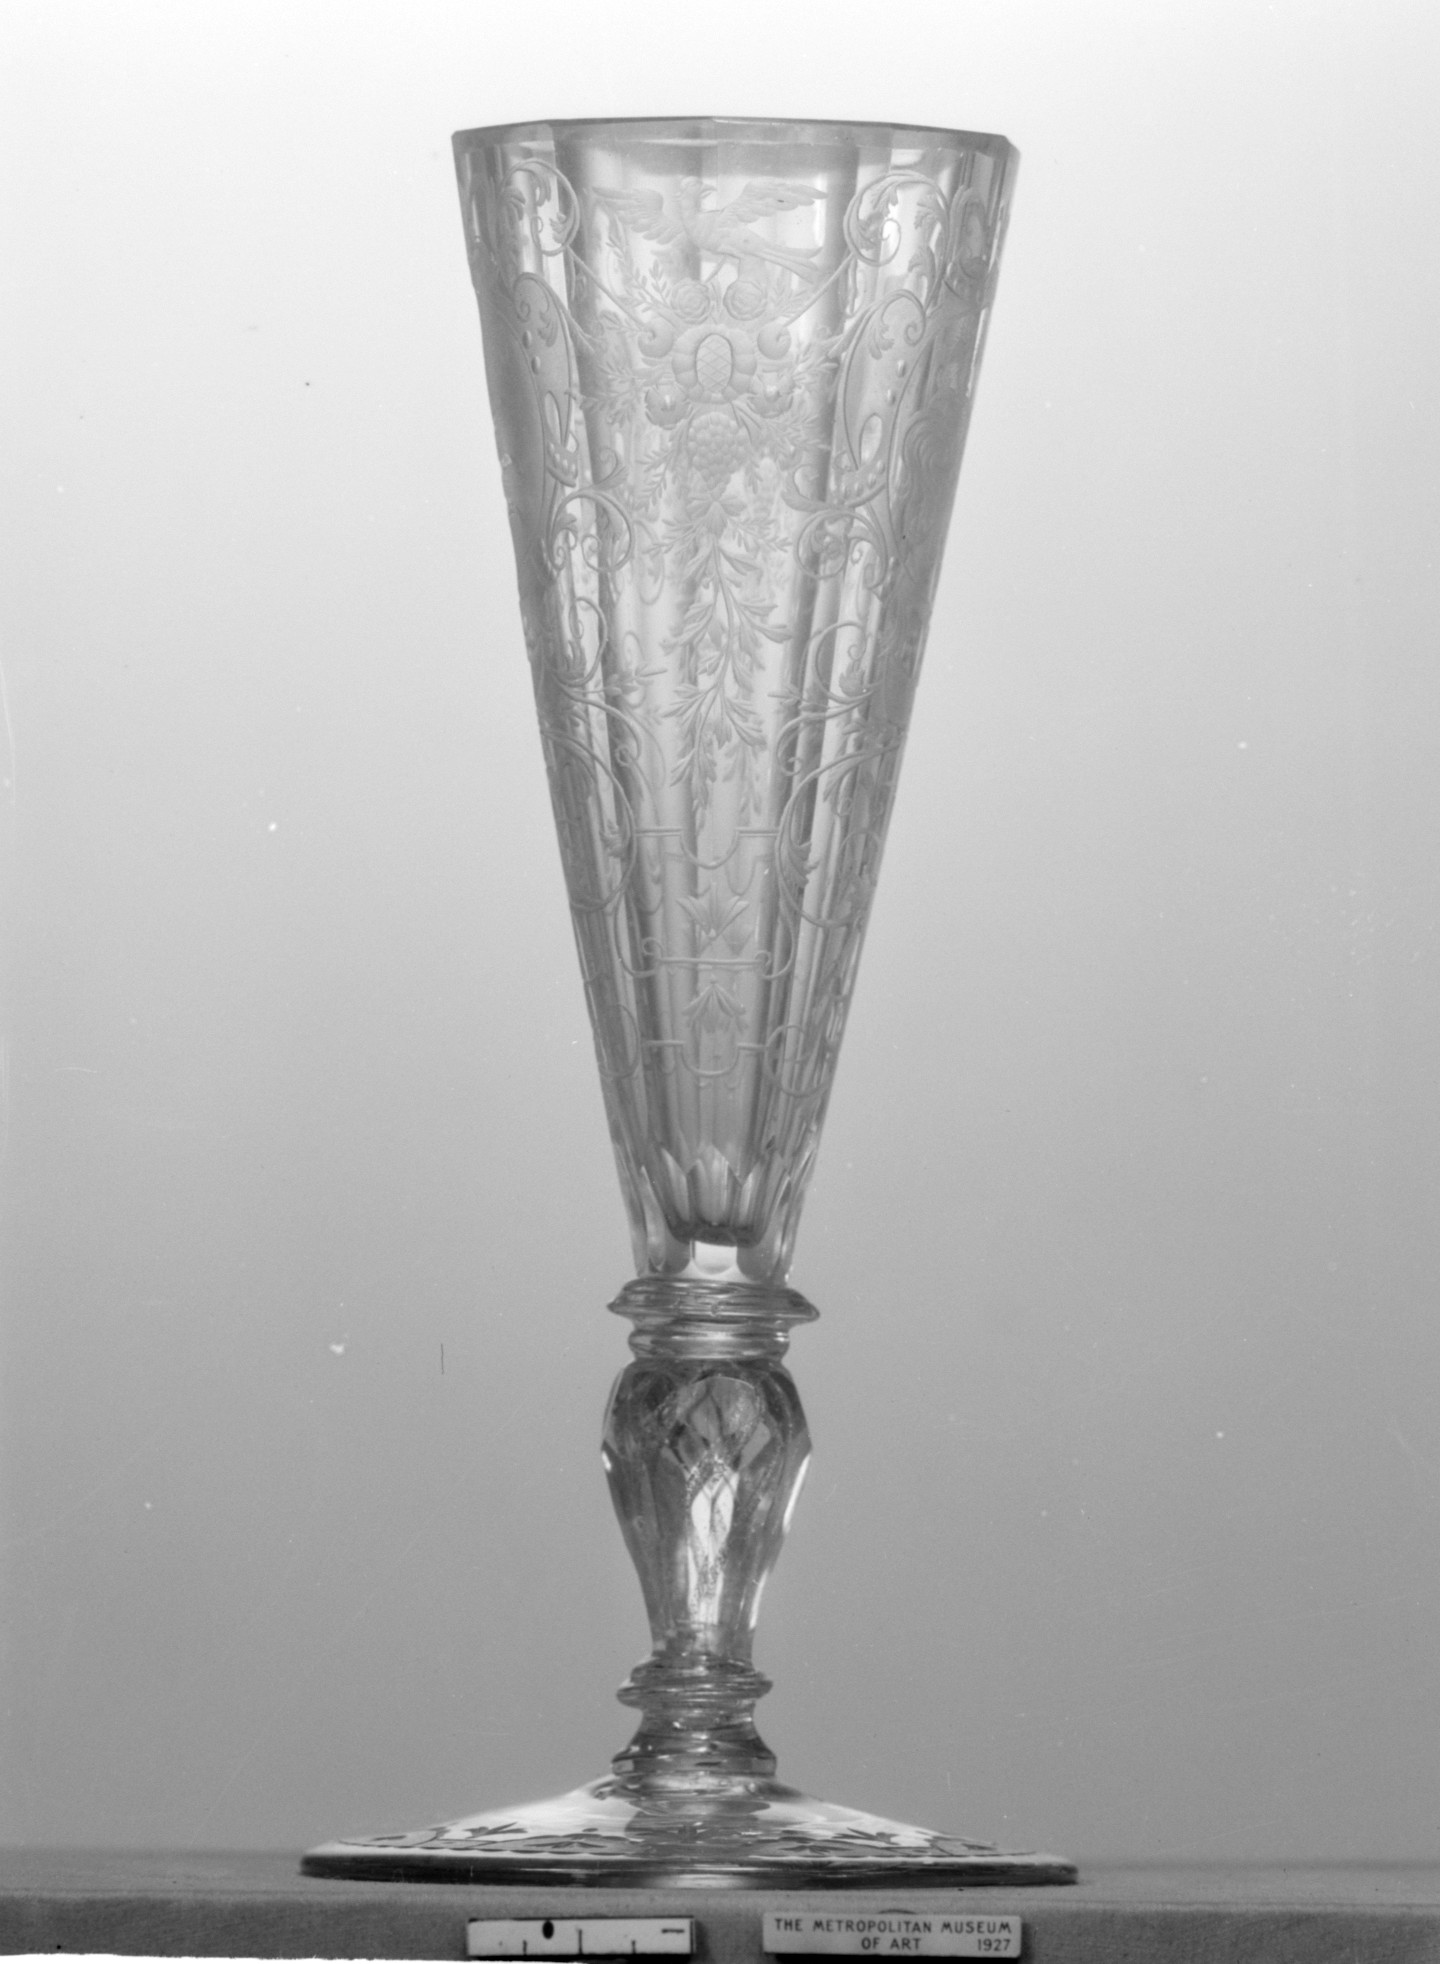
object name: wineglass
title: Wineglass (Spitzglas)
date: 1701-1733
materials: glass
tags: birds,grapes,flowers